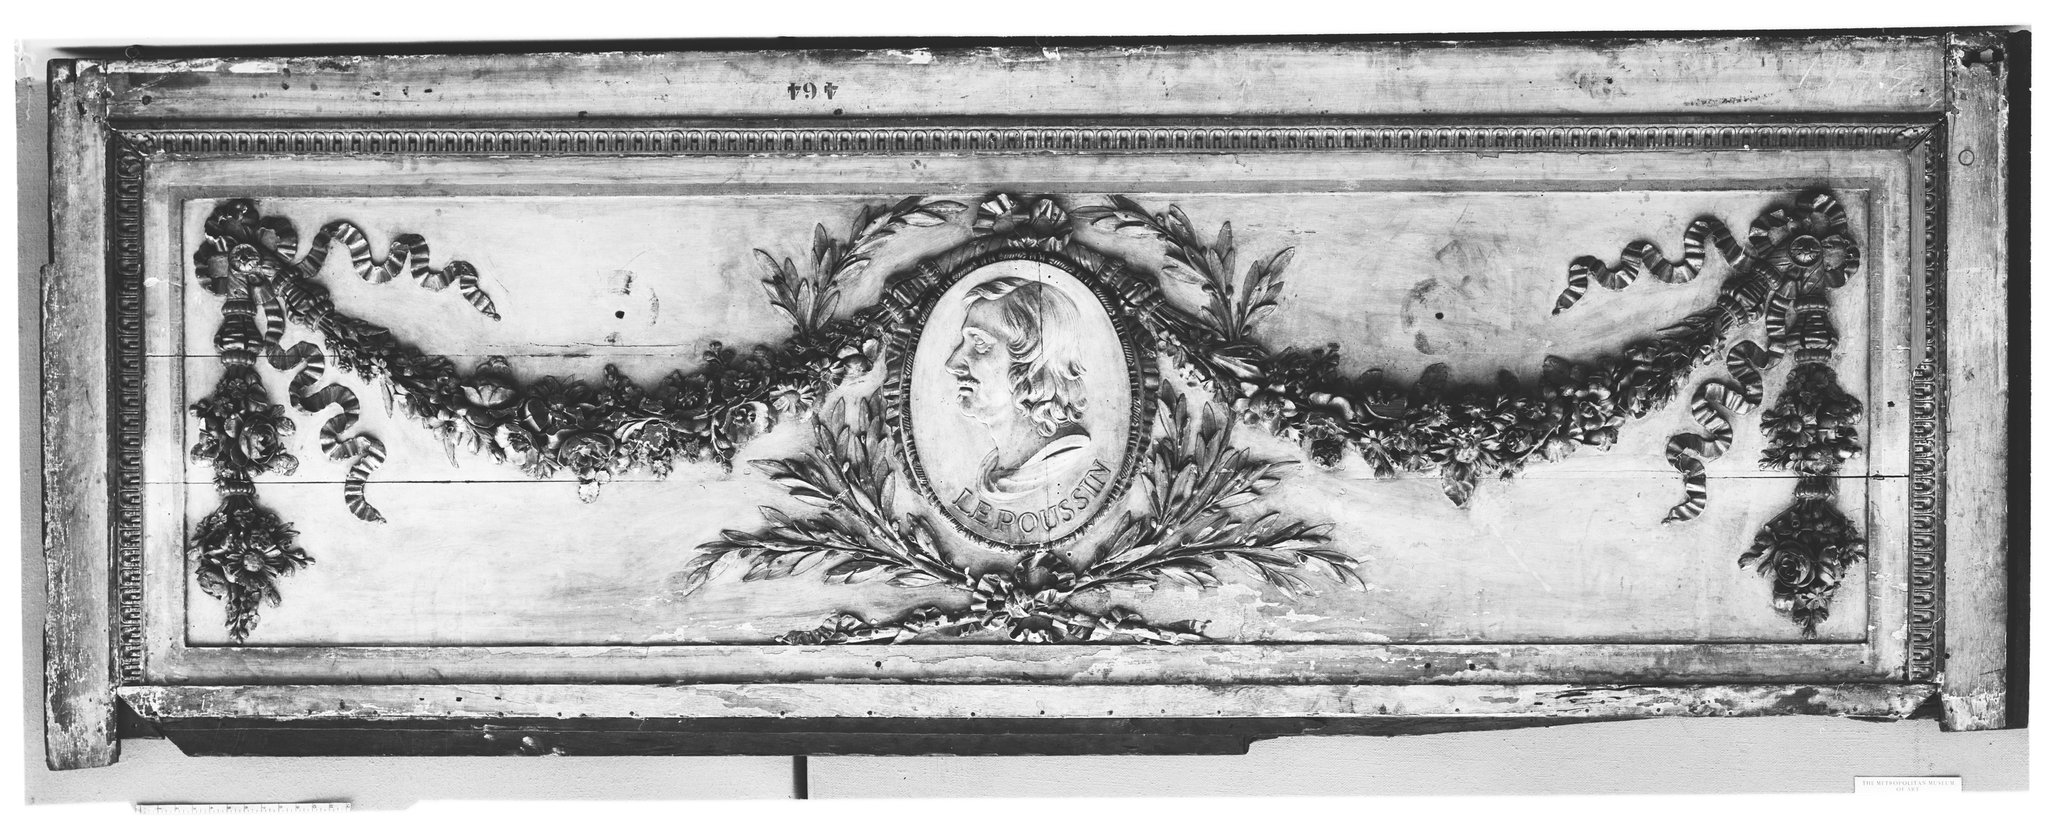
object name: panel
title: Panel for a decorative frieze with portrait of Poussin (from a set of six)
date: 1771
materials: wood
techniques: carving, gilding, painting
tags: profiles,flowers,leaves